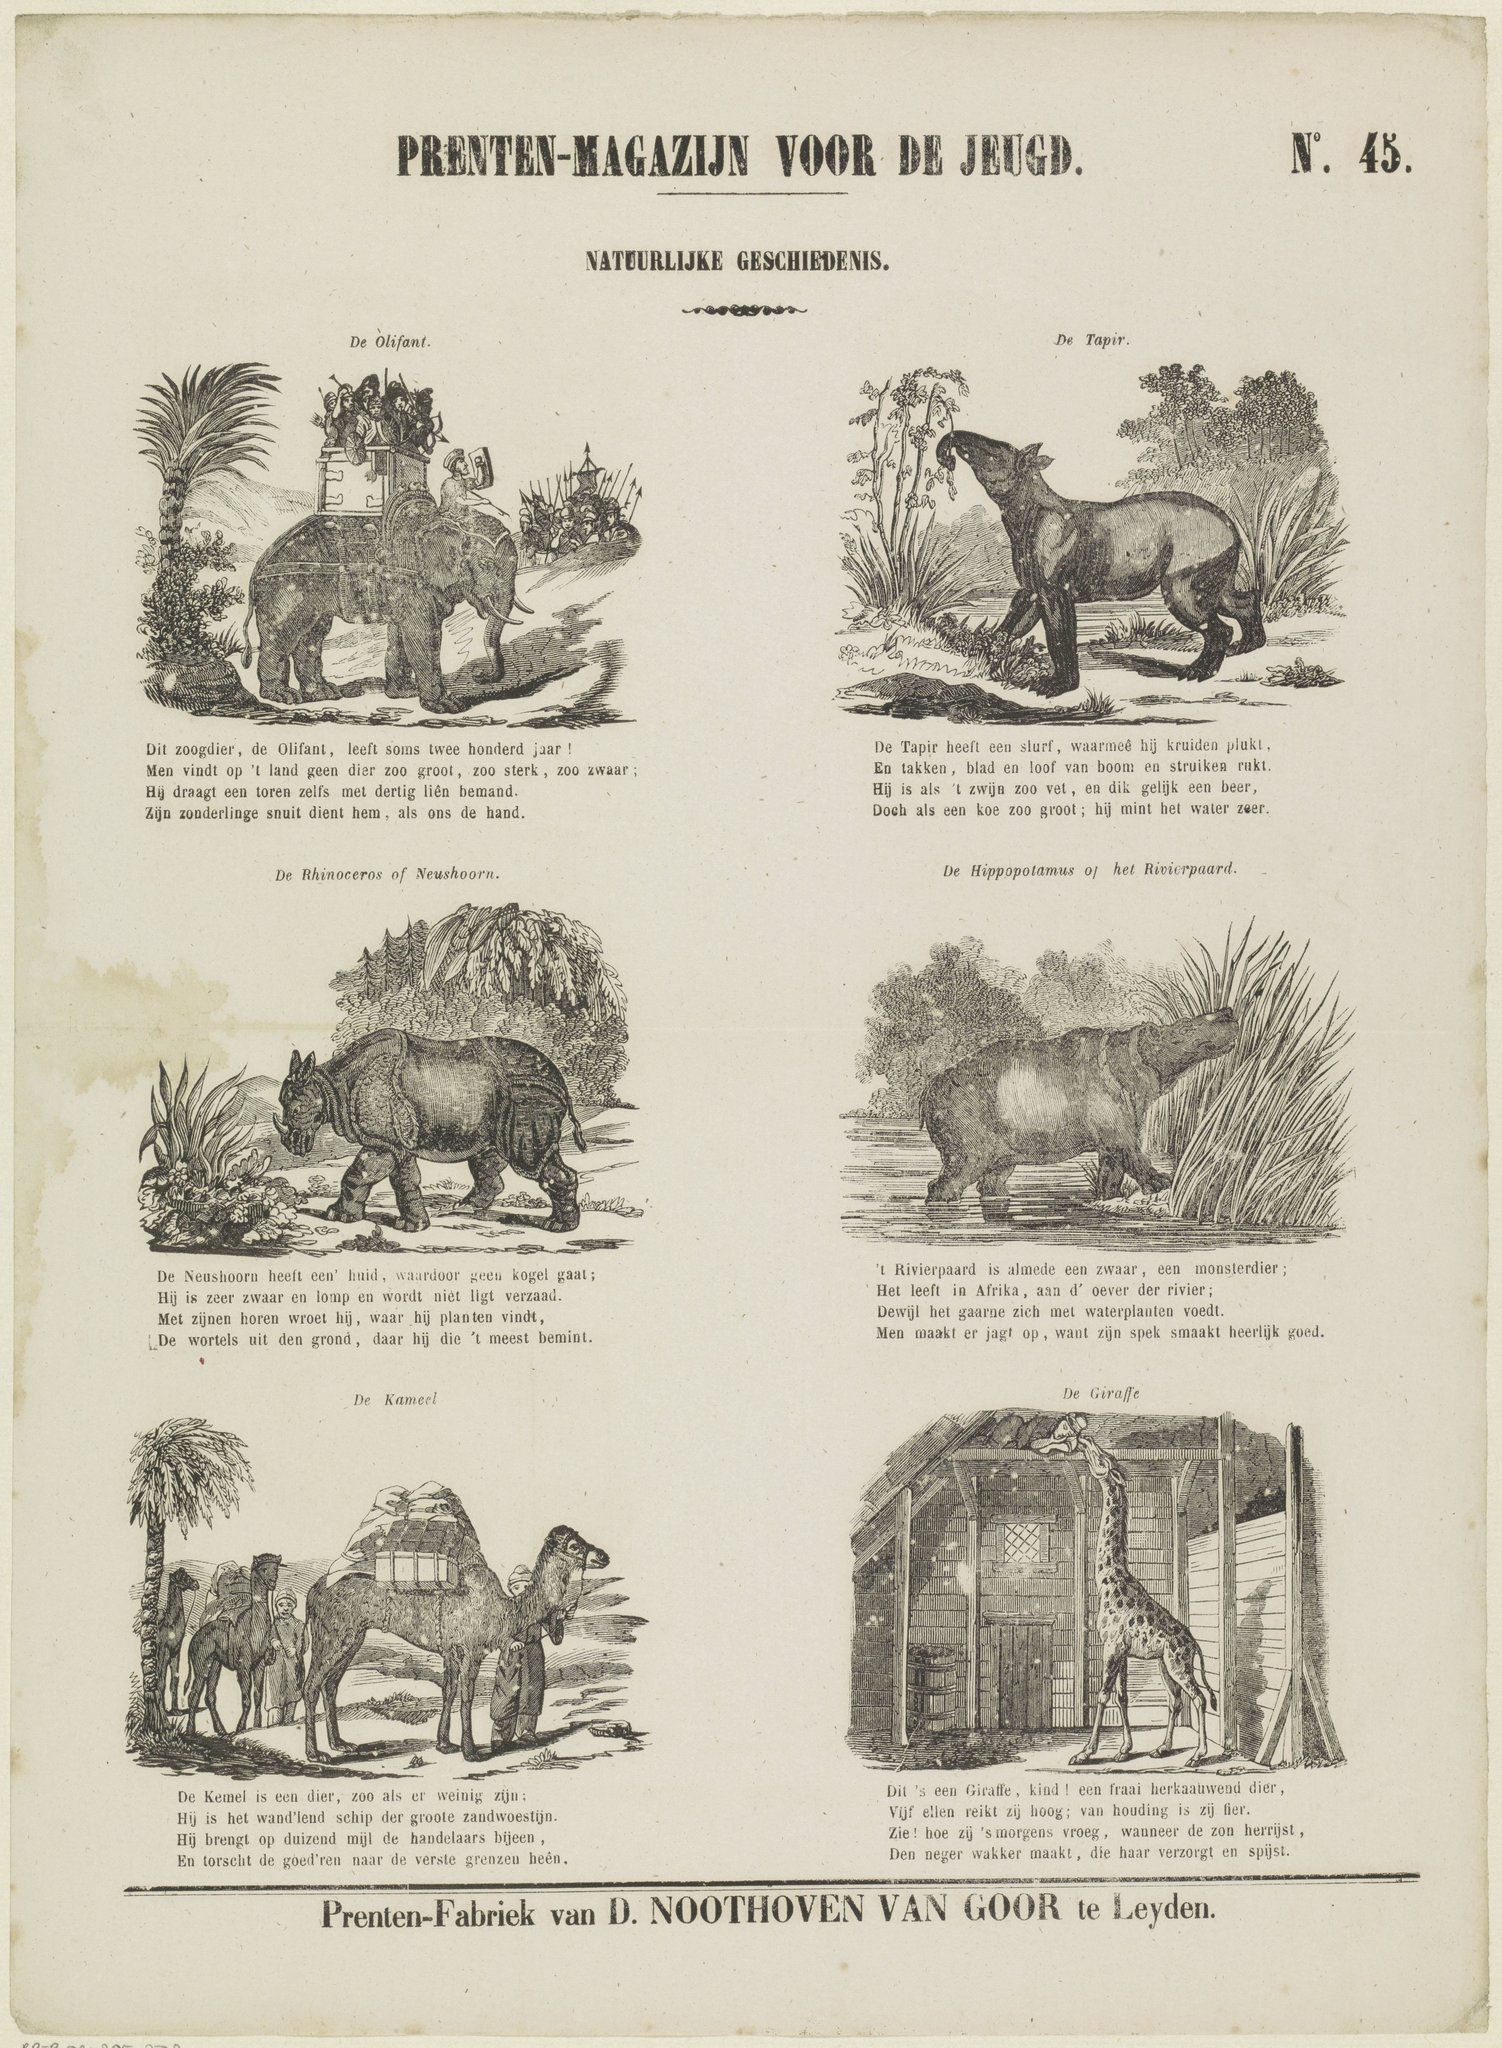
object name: print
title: Dieren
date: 1850-1881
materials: paper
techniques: letterpress printing, engraving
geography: leiden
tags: hoofed animals: camel, hoofed animals: hippopotamus, animals, hoofed animals: rhinoceros, hoofed animals: giraffe, trunked animals: elephant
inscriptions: collector's mark: Lugt 2760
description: Blad met 6 voorstellingen van verschillende dieren: een olifant, een tapir, een neushoorn, een nijlpaard, een kameel en een giraffe. Boven elke voorstelling een titel en onder elke voorstelling een vierregelig vers. Genummerd rechtsboven: No. 45.